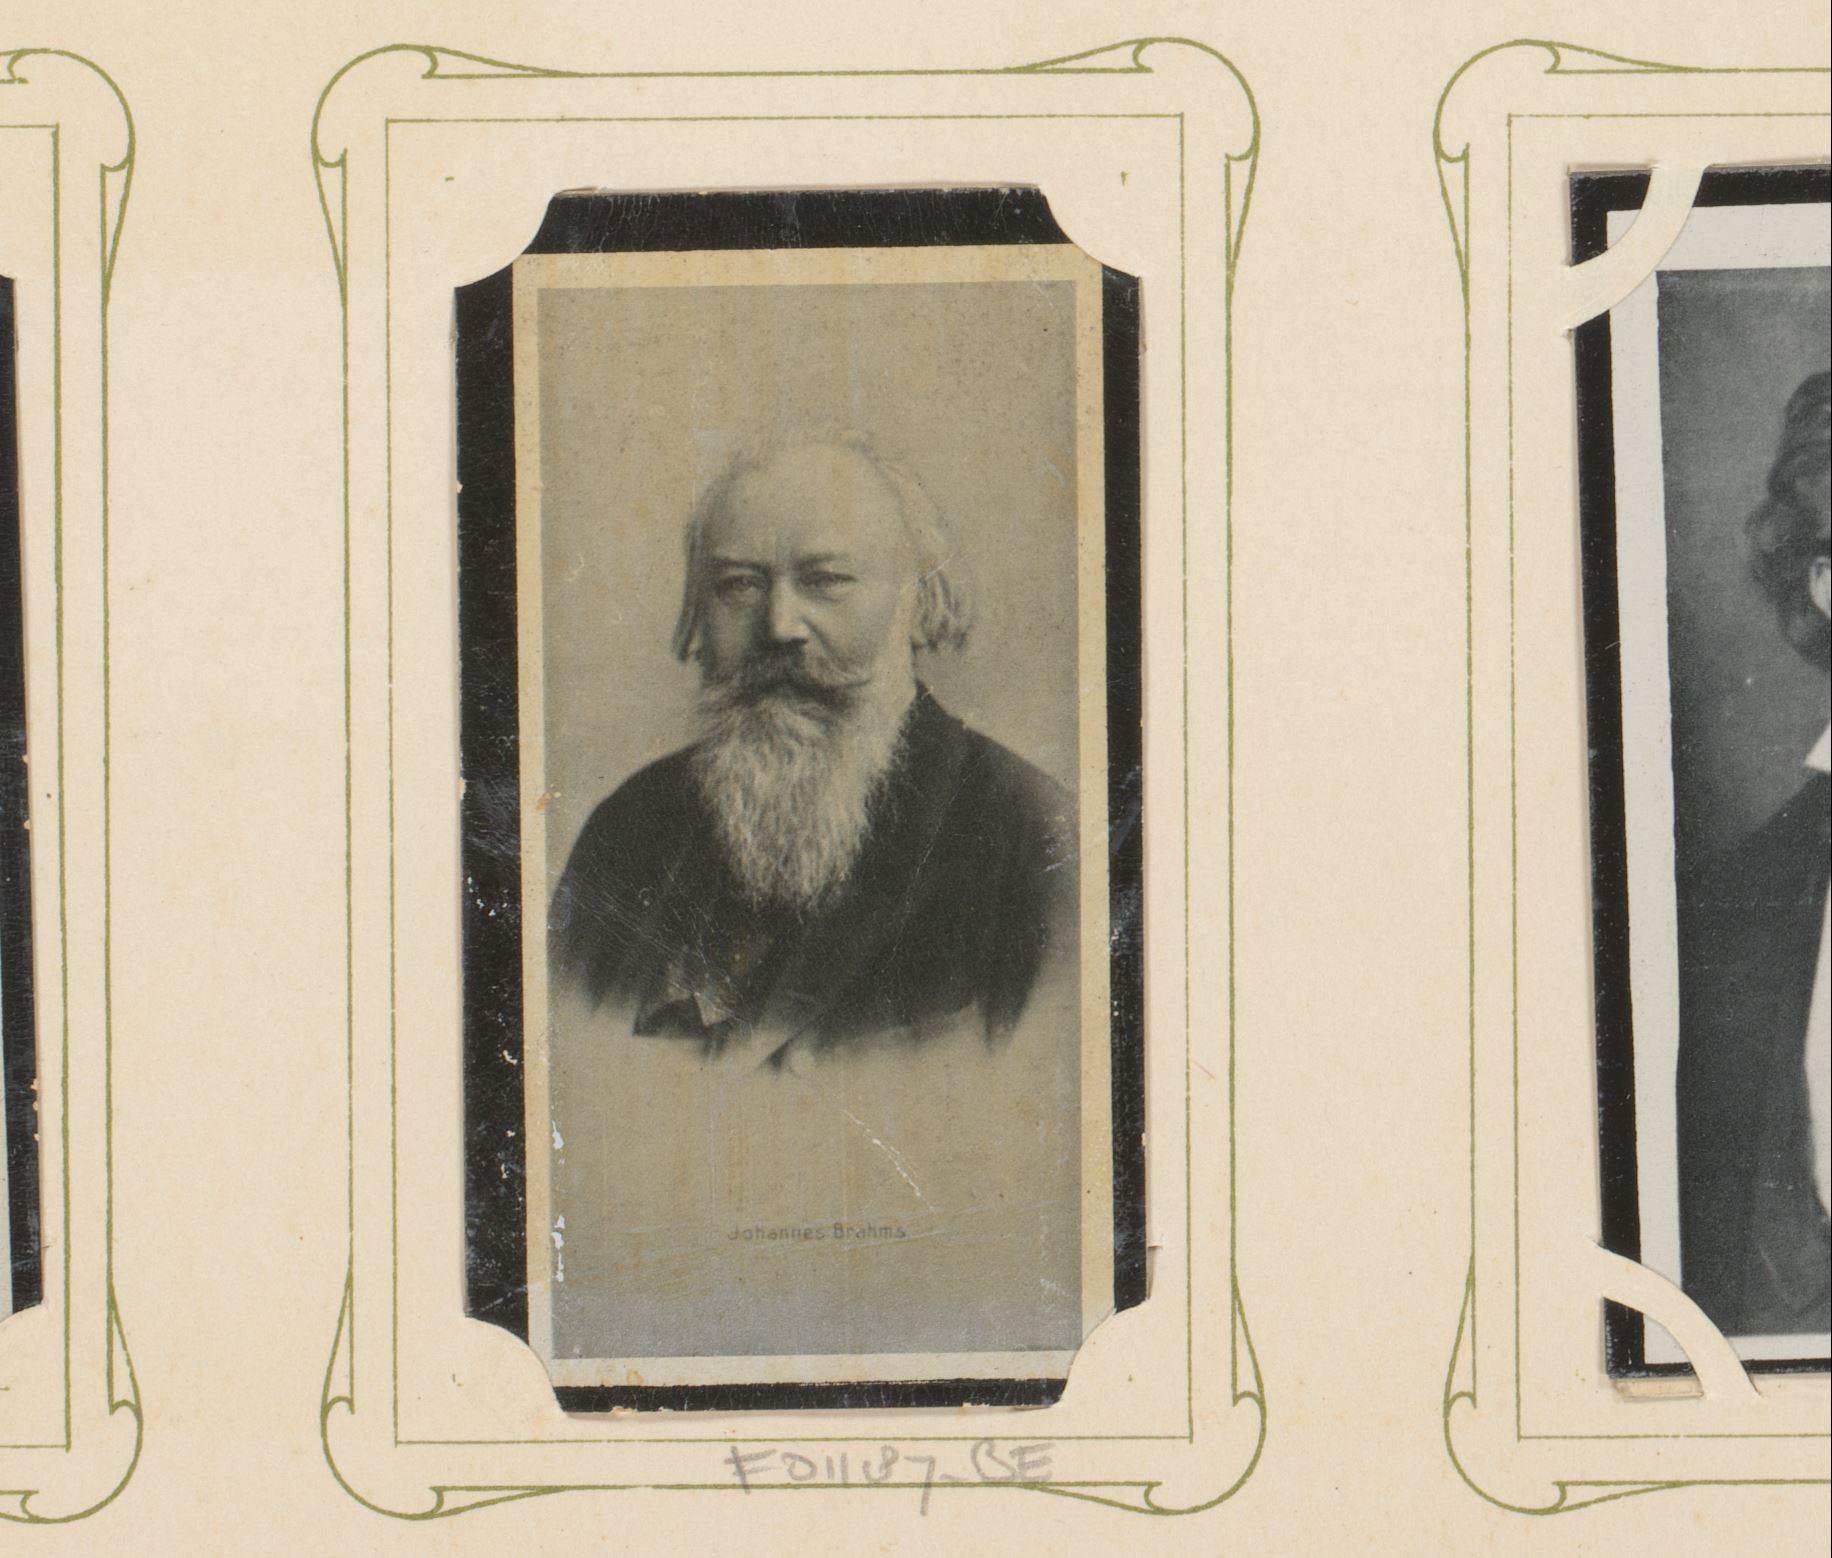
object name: album leaf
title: Portret van Johannes Brahms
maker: Anonymous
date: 1905-1906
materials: paper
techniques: photograph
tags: vienna, johannes brahms, historical persons, portrait of composer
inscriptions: inscription: ‘No. 5./ Johannes Brahms.’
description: Deze prent maakt deel uit van een album.